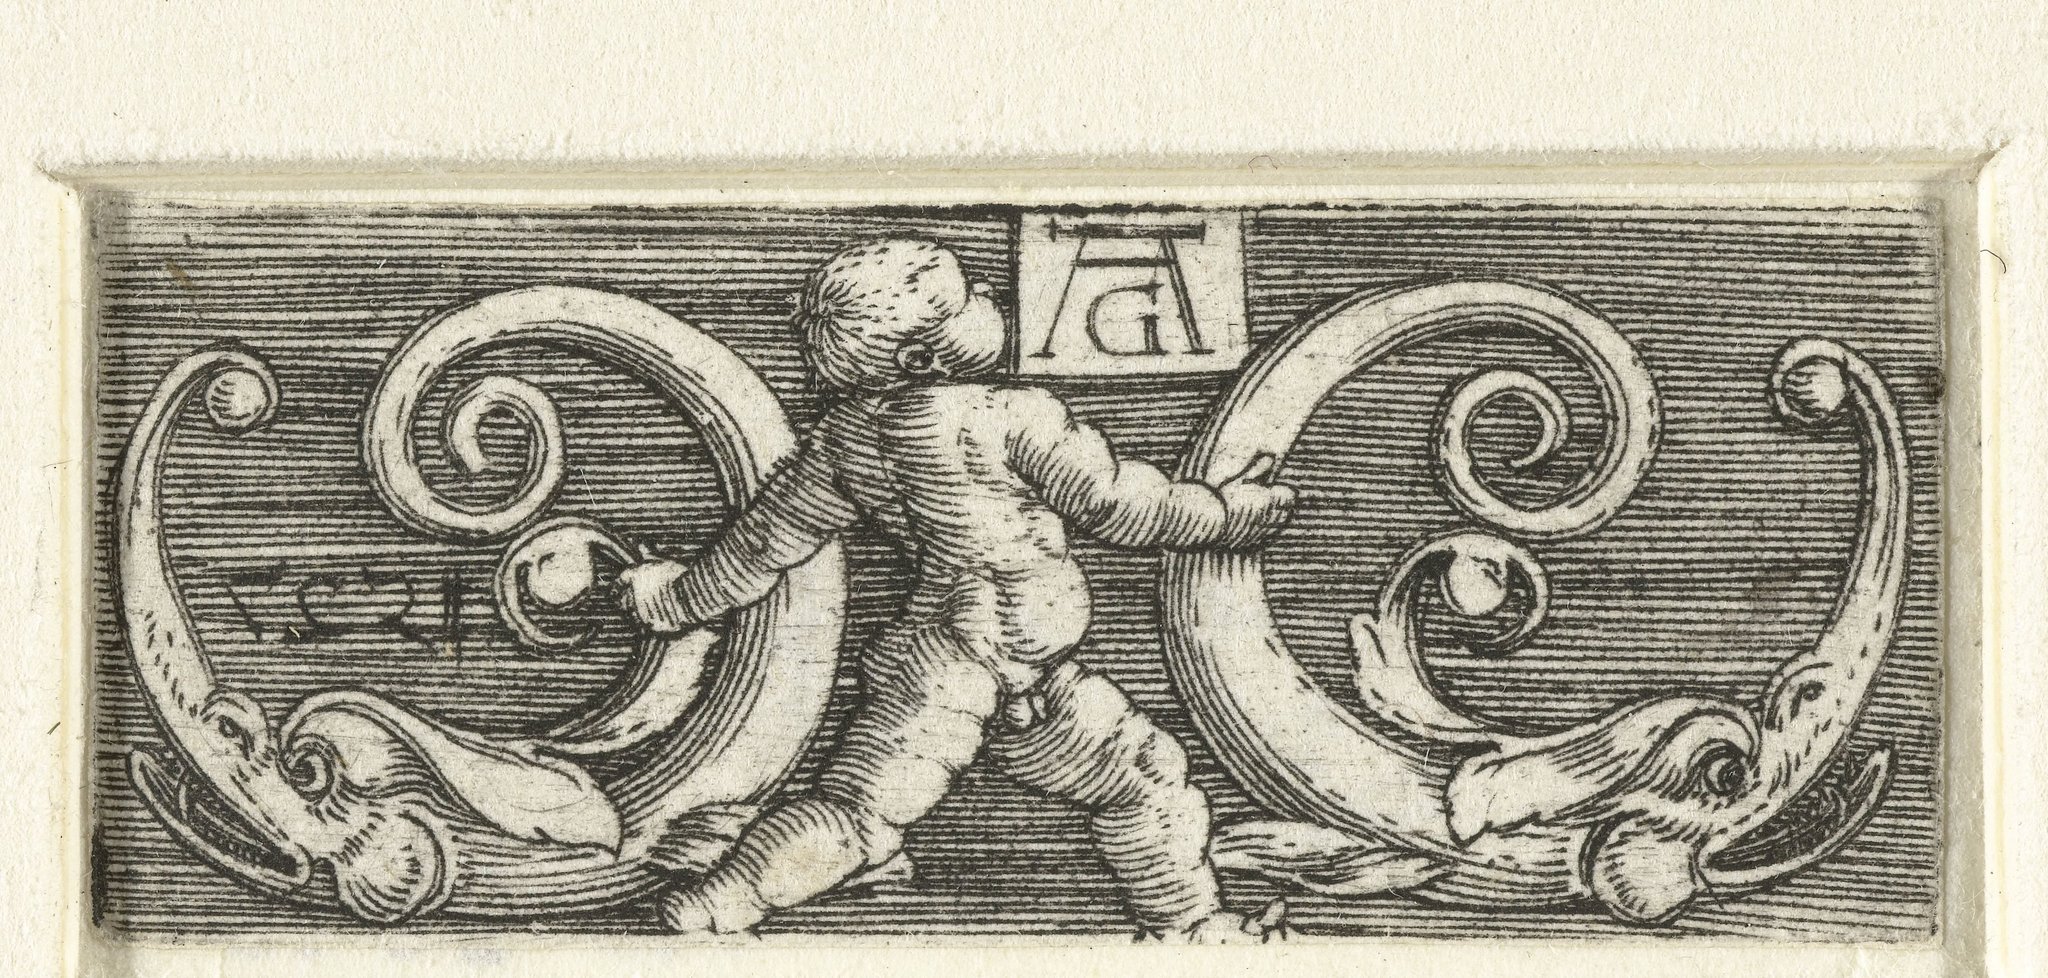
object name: ornament print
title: Fries met putto en twee dolfijnen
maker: heinrich aldegrever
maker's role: draughtsman, print maker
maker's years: 1502-1561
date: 1527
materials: paper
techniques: engraving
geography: germany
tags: dolphin ~ ornament, child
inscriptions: number: ‘9’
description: Fries met kind op de rug gezien, tussen twee dolfijnen.